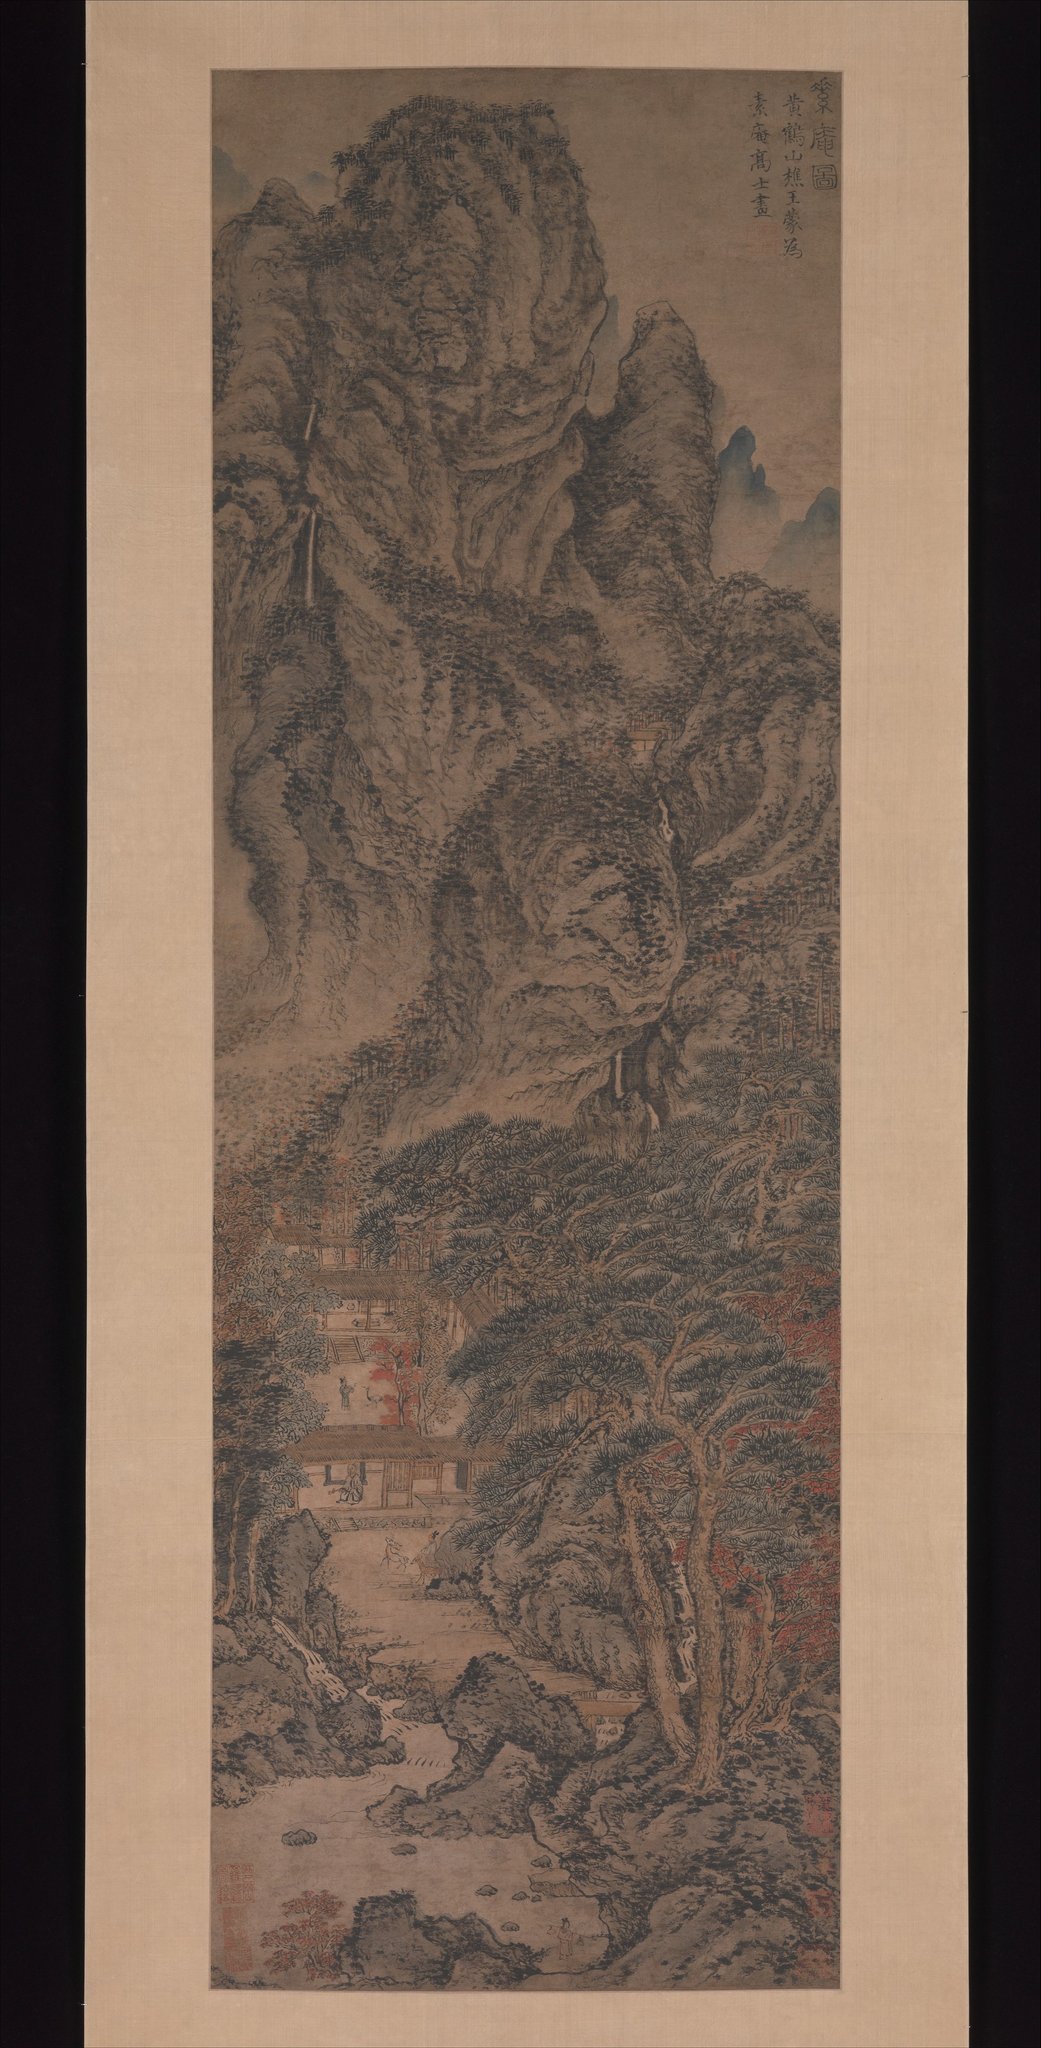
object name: hanging scroll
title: Simple Retreat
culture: chinese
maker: wang meng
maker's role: artist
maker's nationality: chinese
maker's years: 1308-1385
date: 1370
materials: ink, paper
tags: mountains,landscapes